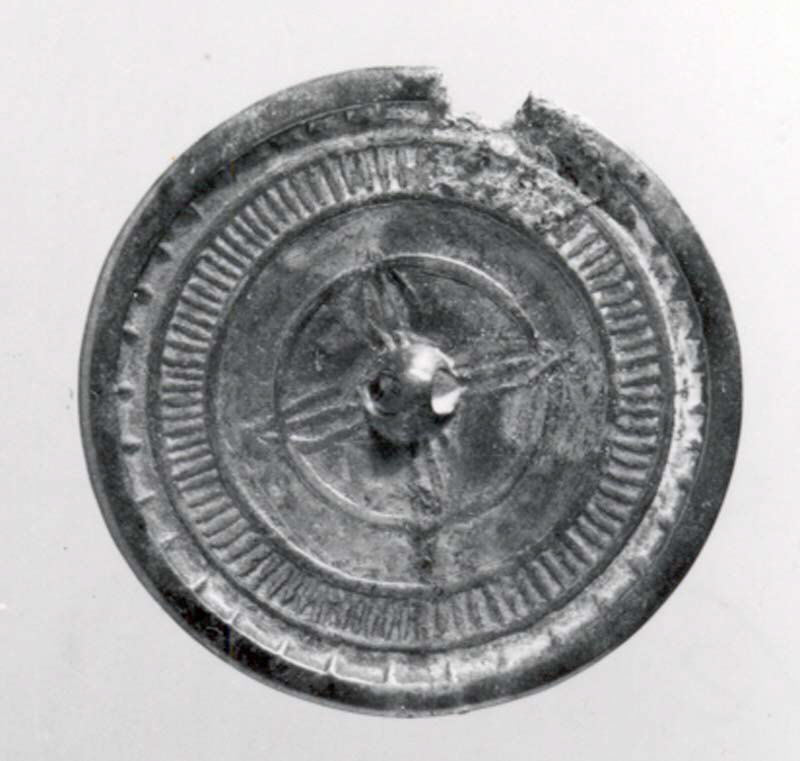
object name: mirror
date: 400-201 BCE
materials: bronze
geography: eastern eurasian steppes